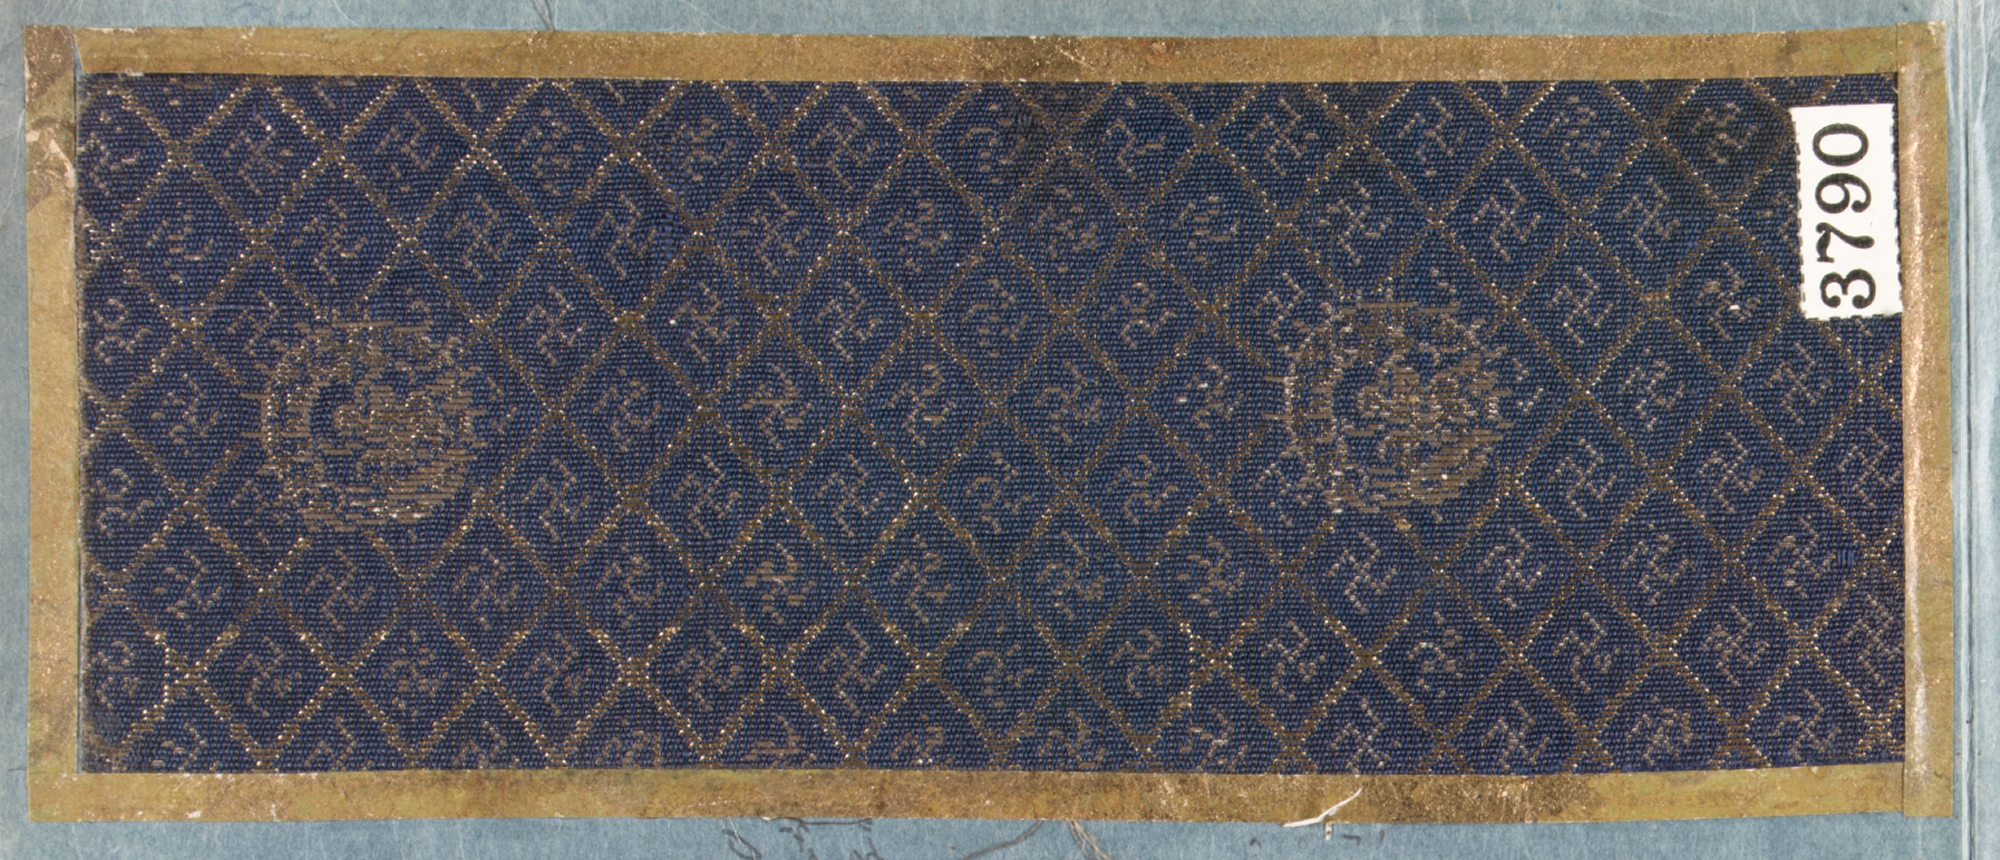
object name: sample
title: Textile Sample from Sample Book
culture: japanese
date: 1801-1900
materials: silk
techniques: tapestry